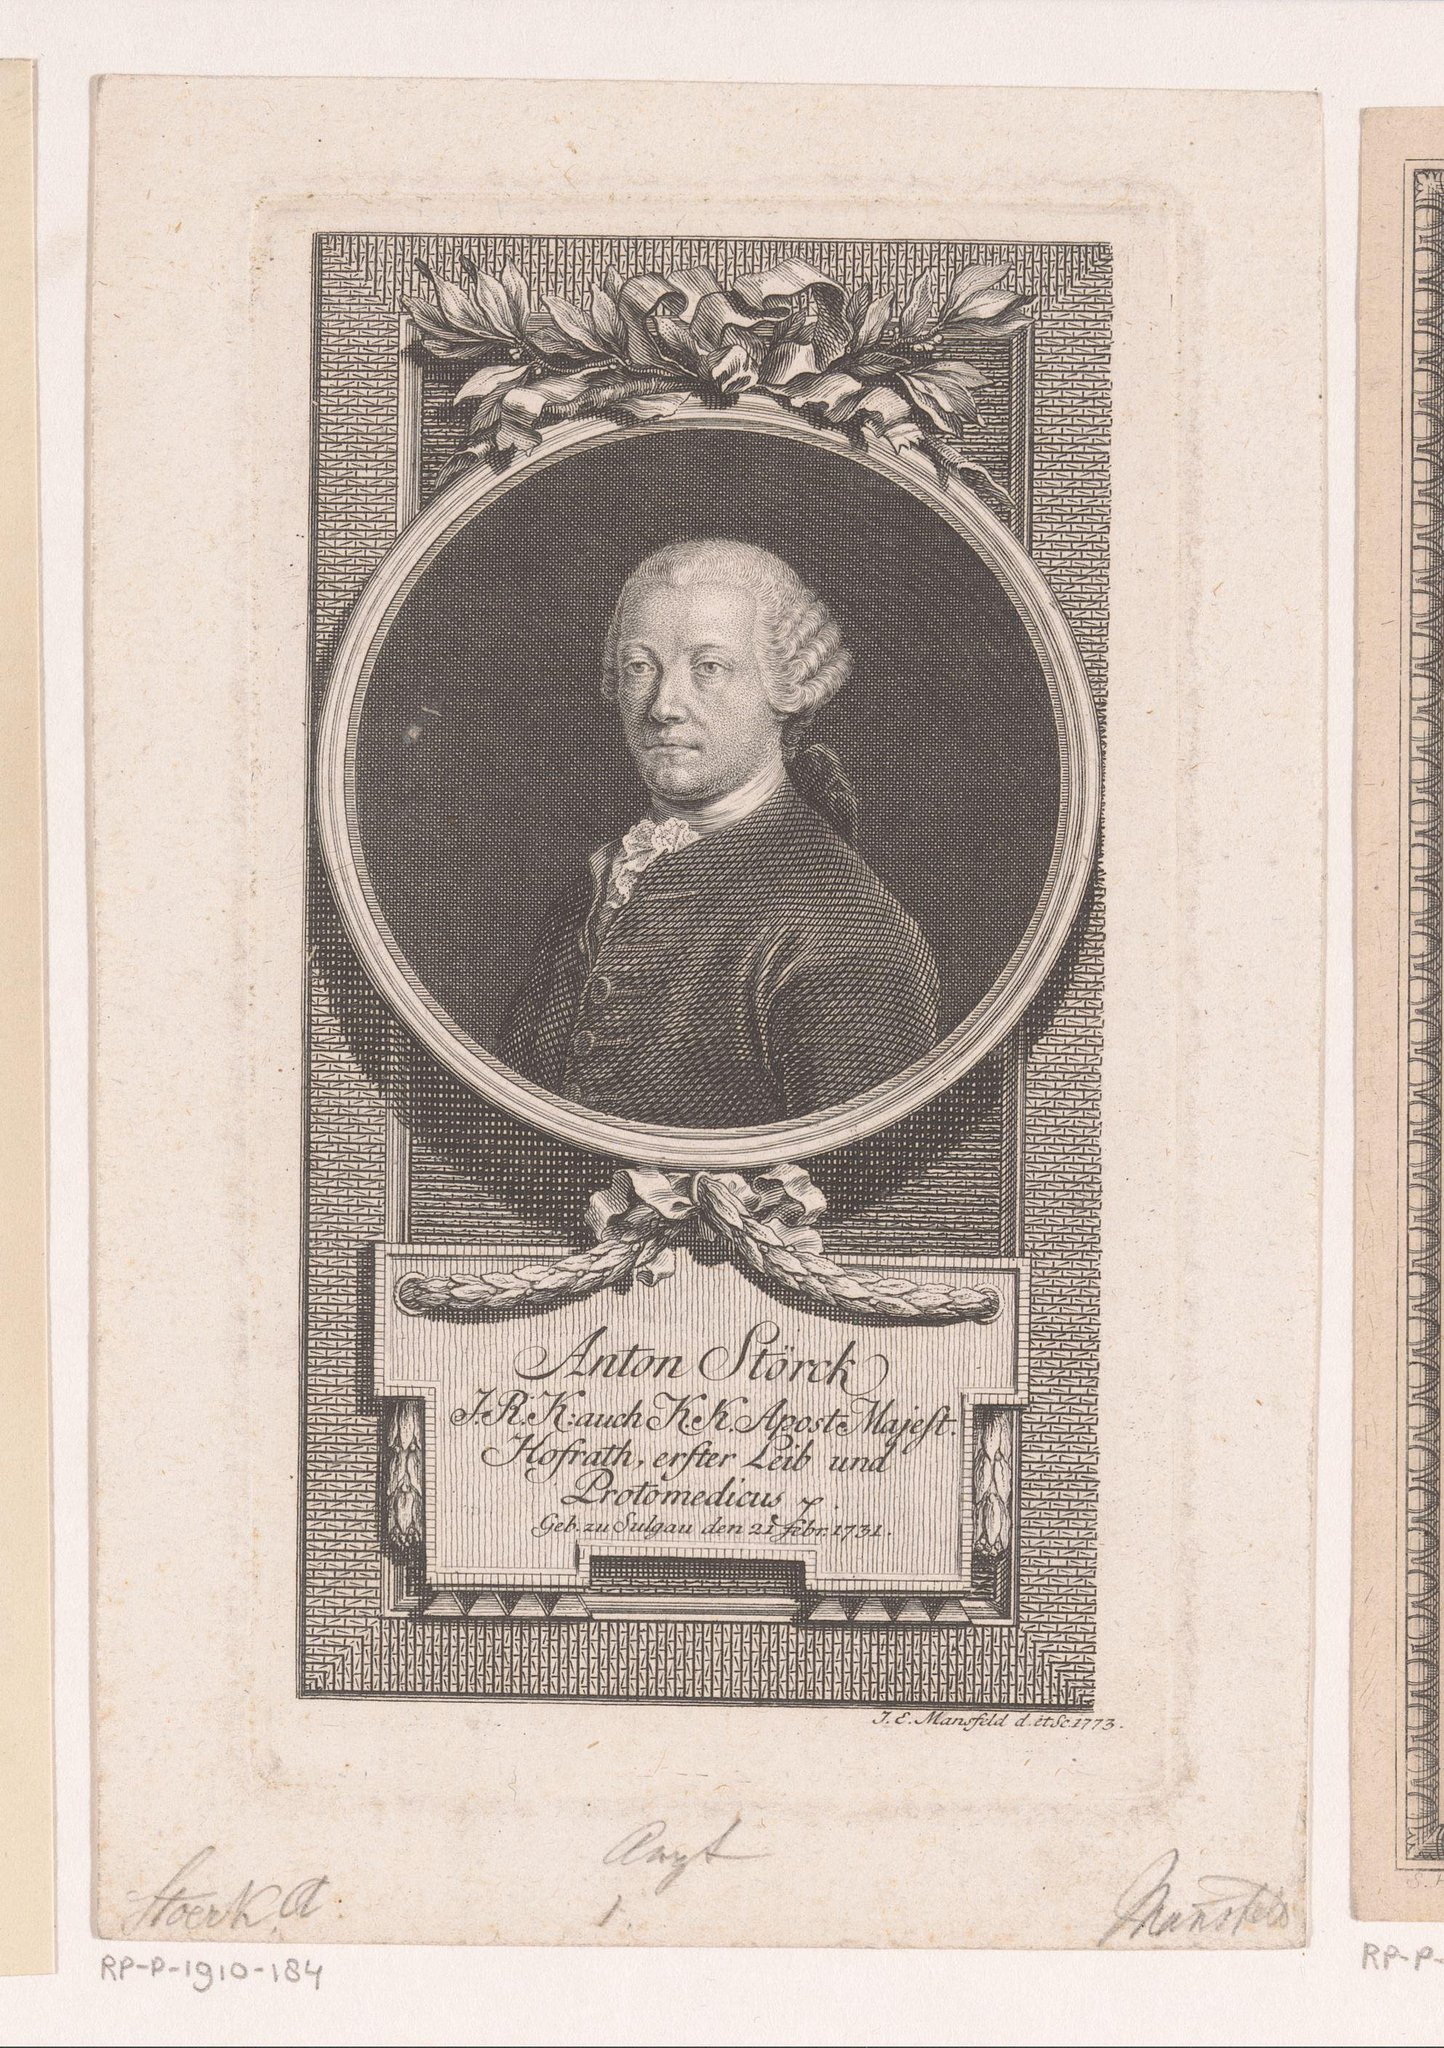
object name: print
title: Portret van Anton von Störck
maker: johann ernst mansfeld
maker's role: print maker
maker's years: 1739-1796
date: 1773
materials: paper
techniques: engraving, etching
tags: vienna, historical persons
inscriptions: collector's mark: Lugt 2228